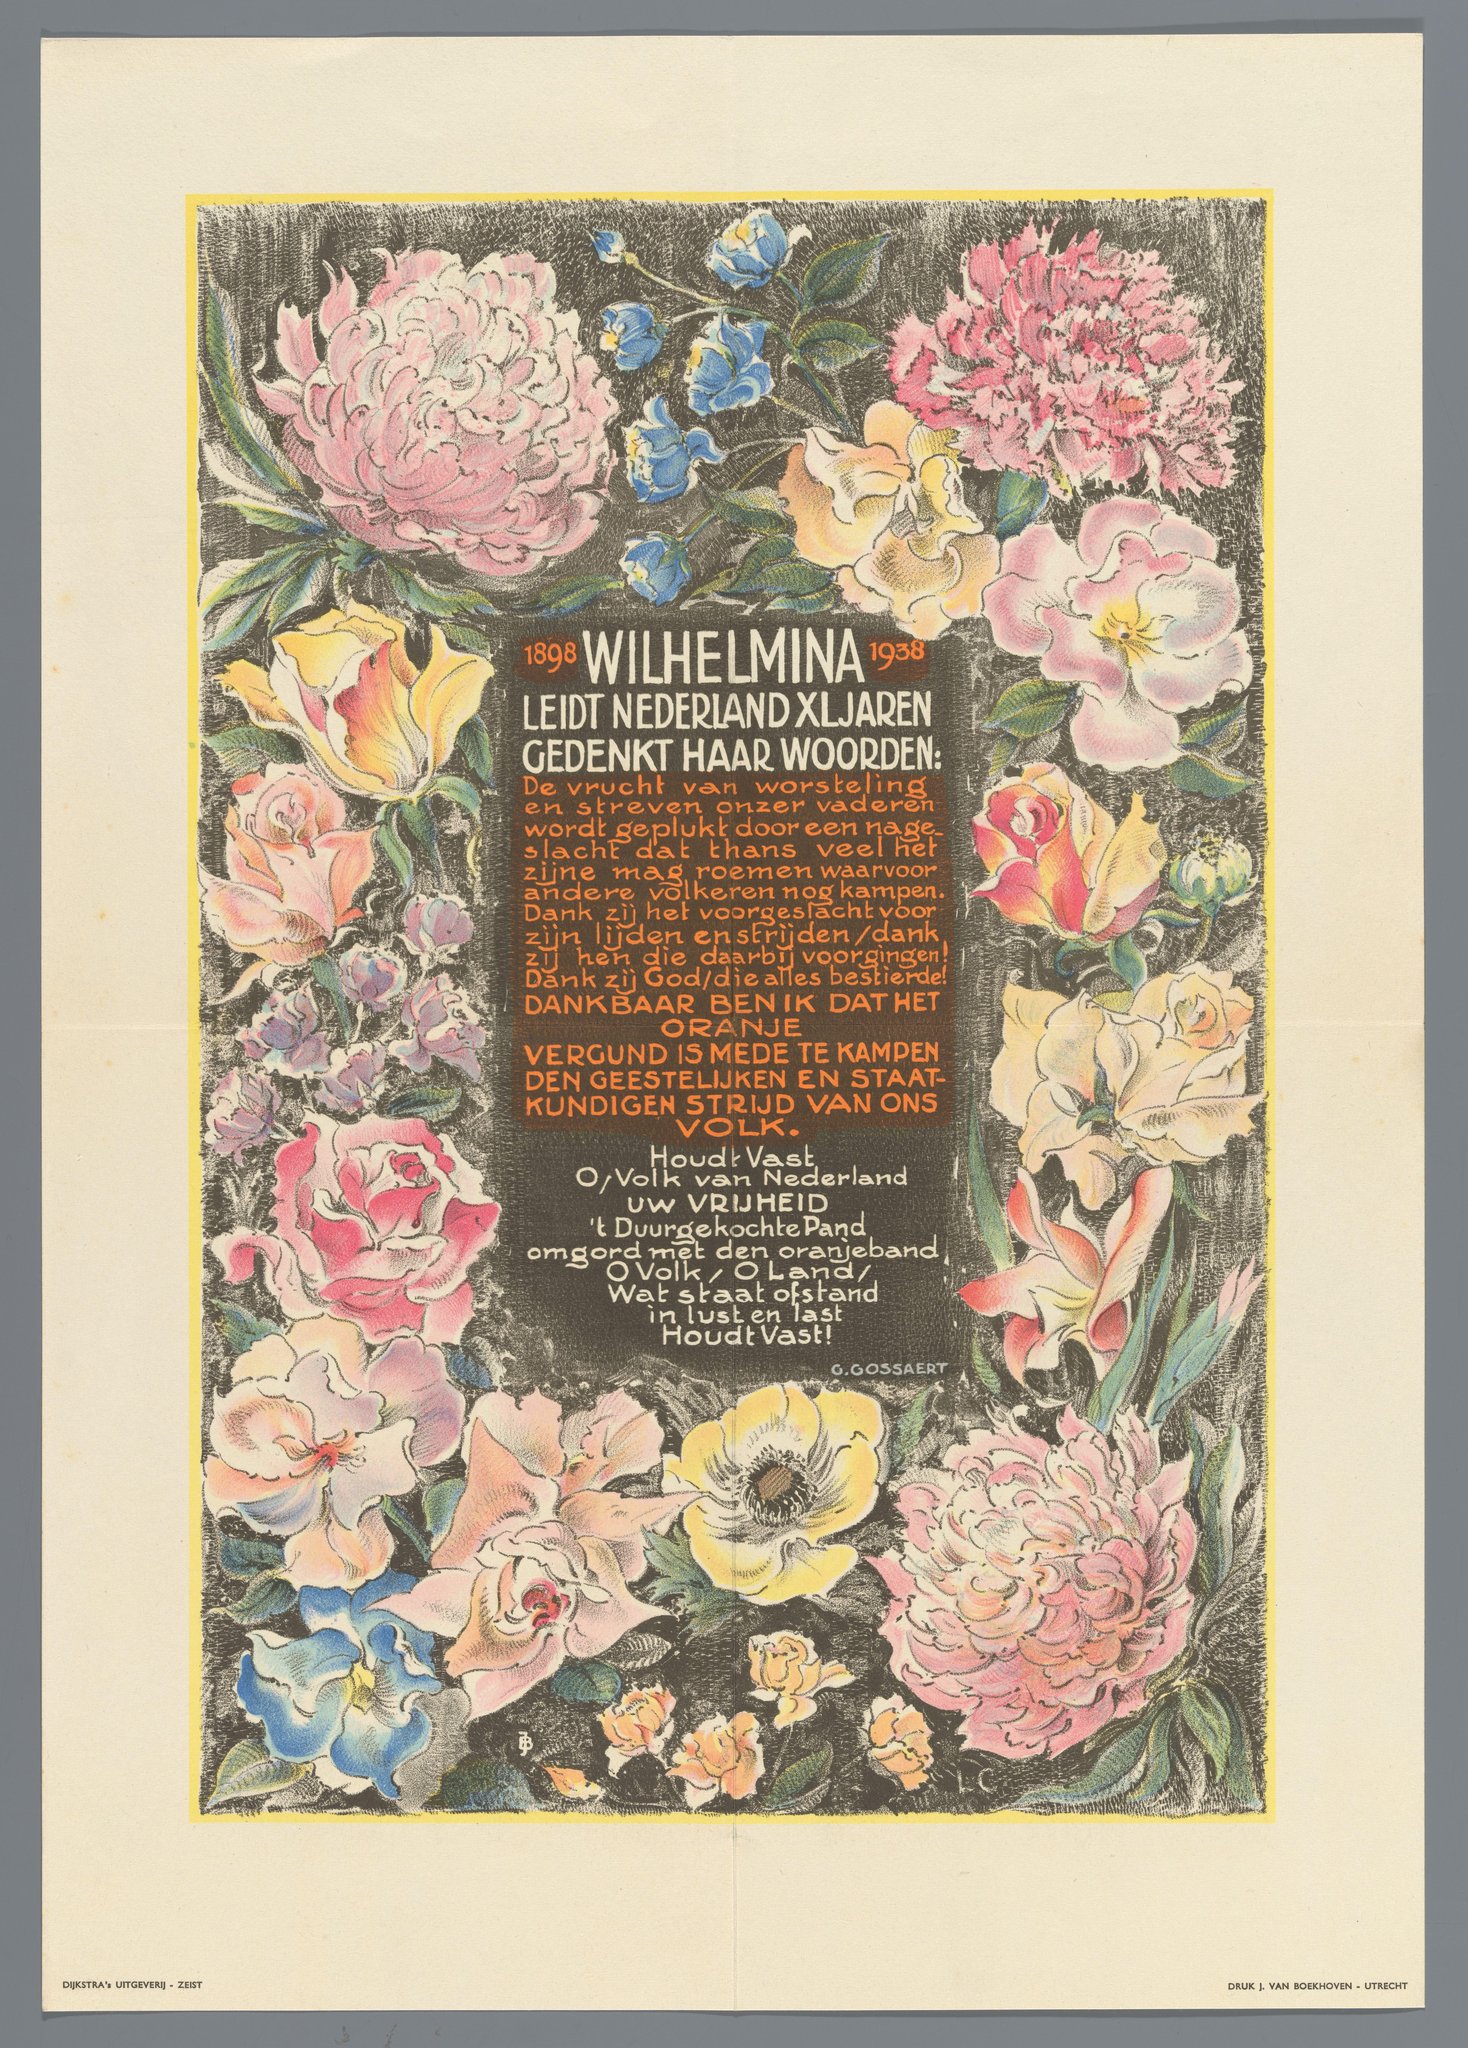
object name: gelegenheidsdrukwerk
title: Wilhelmina leidt Nederland XL jaren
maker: monogrammist jb (20e eeuw)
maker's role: schrijver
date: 1938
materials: paper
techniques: printing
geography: zeist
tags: the hague, print maker, wilhelmina of the netherlands, netherlands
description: Drukwerk, uitgegeven ter gelegenheid van het 40 jarig regeringsjubileum van Koningin Wilhelmina in 1938, wit papier, eenzijdig bedrukt met meer kleuren, tekst in wit en oranje omgeven door diverse bloemen.